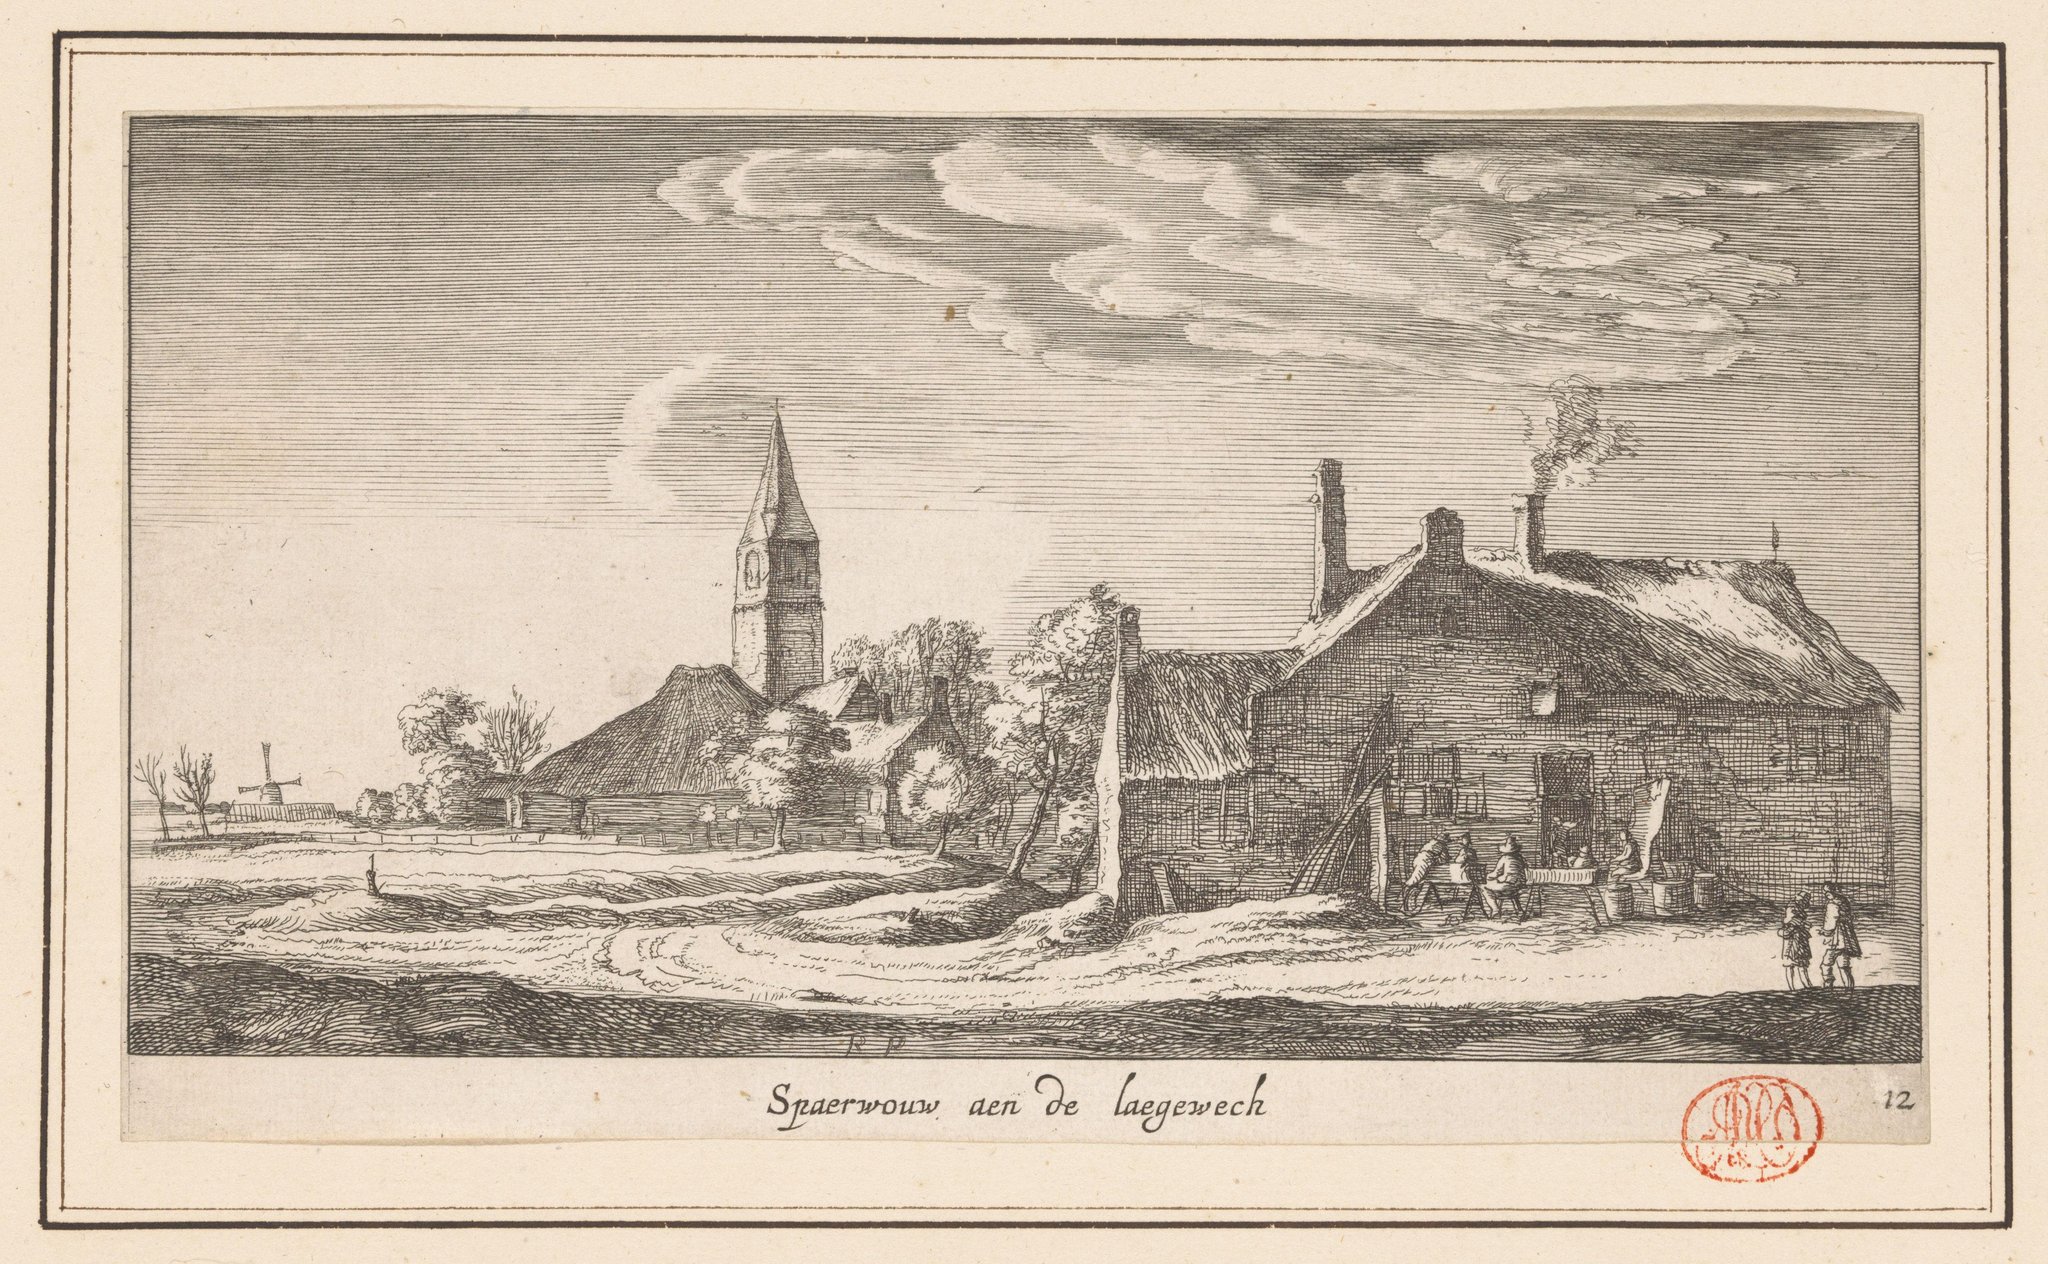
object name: print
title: Plaisante Lantschappen ofte vermakelijcke Gesichten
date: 1637-1652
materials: paper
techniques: engraving, etching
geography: amsterdam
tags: prospect of village, silhouette of village, church (exterior), hotel, hostelry, inn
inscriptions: collector's mark: Lugt 195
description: Gezicht op Spaarnwoude, met op de voorgrond een herberg en links de kerk. De prent is deel van een serie landschappen met dorpen rondom Amsterdam. Rechtsonder genummerd: 12.